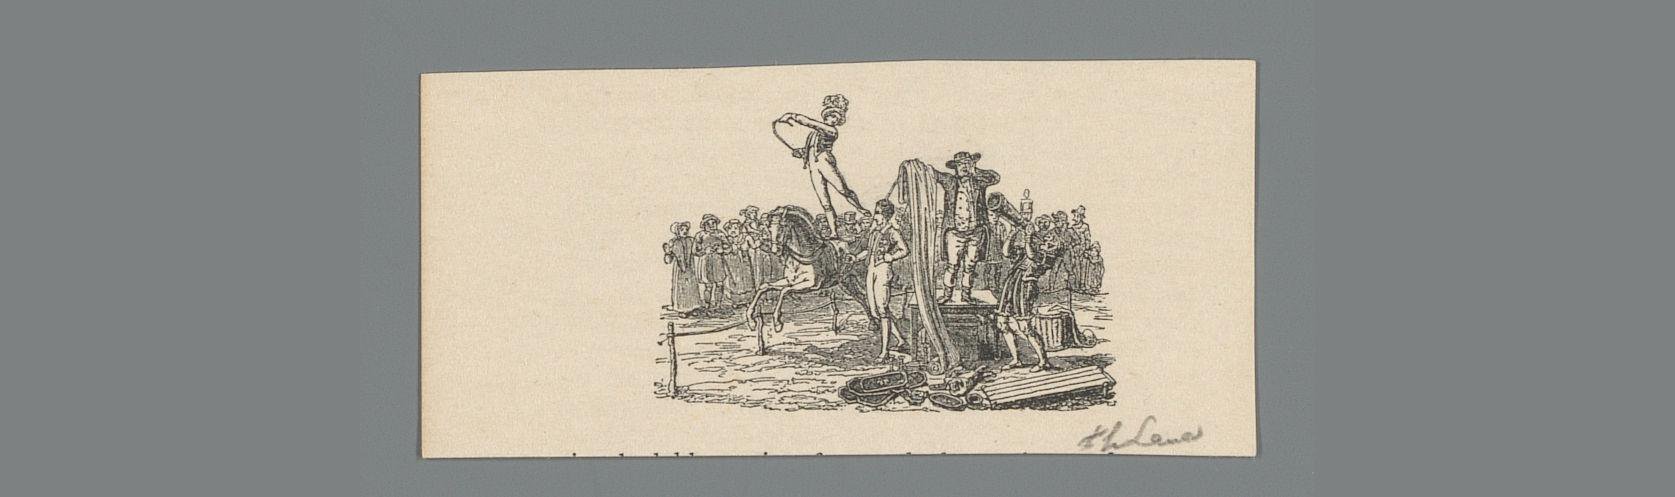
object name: print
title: Optreden te paard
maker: theodore lane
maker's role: draughtsman, painter, print maker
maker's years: 1800-1828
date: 1823-1825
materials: paper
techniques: etching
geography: england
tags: circus animals, circus, political caricatures and satires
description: Artiest staand op de rug van een paard, bij een circusvoorstelling in de open lucht. Onderdeel van een groep van zeven boekillustraties uit: The Life of an Actor (1825).